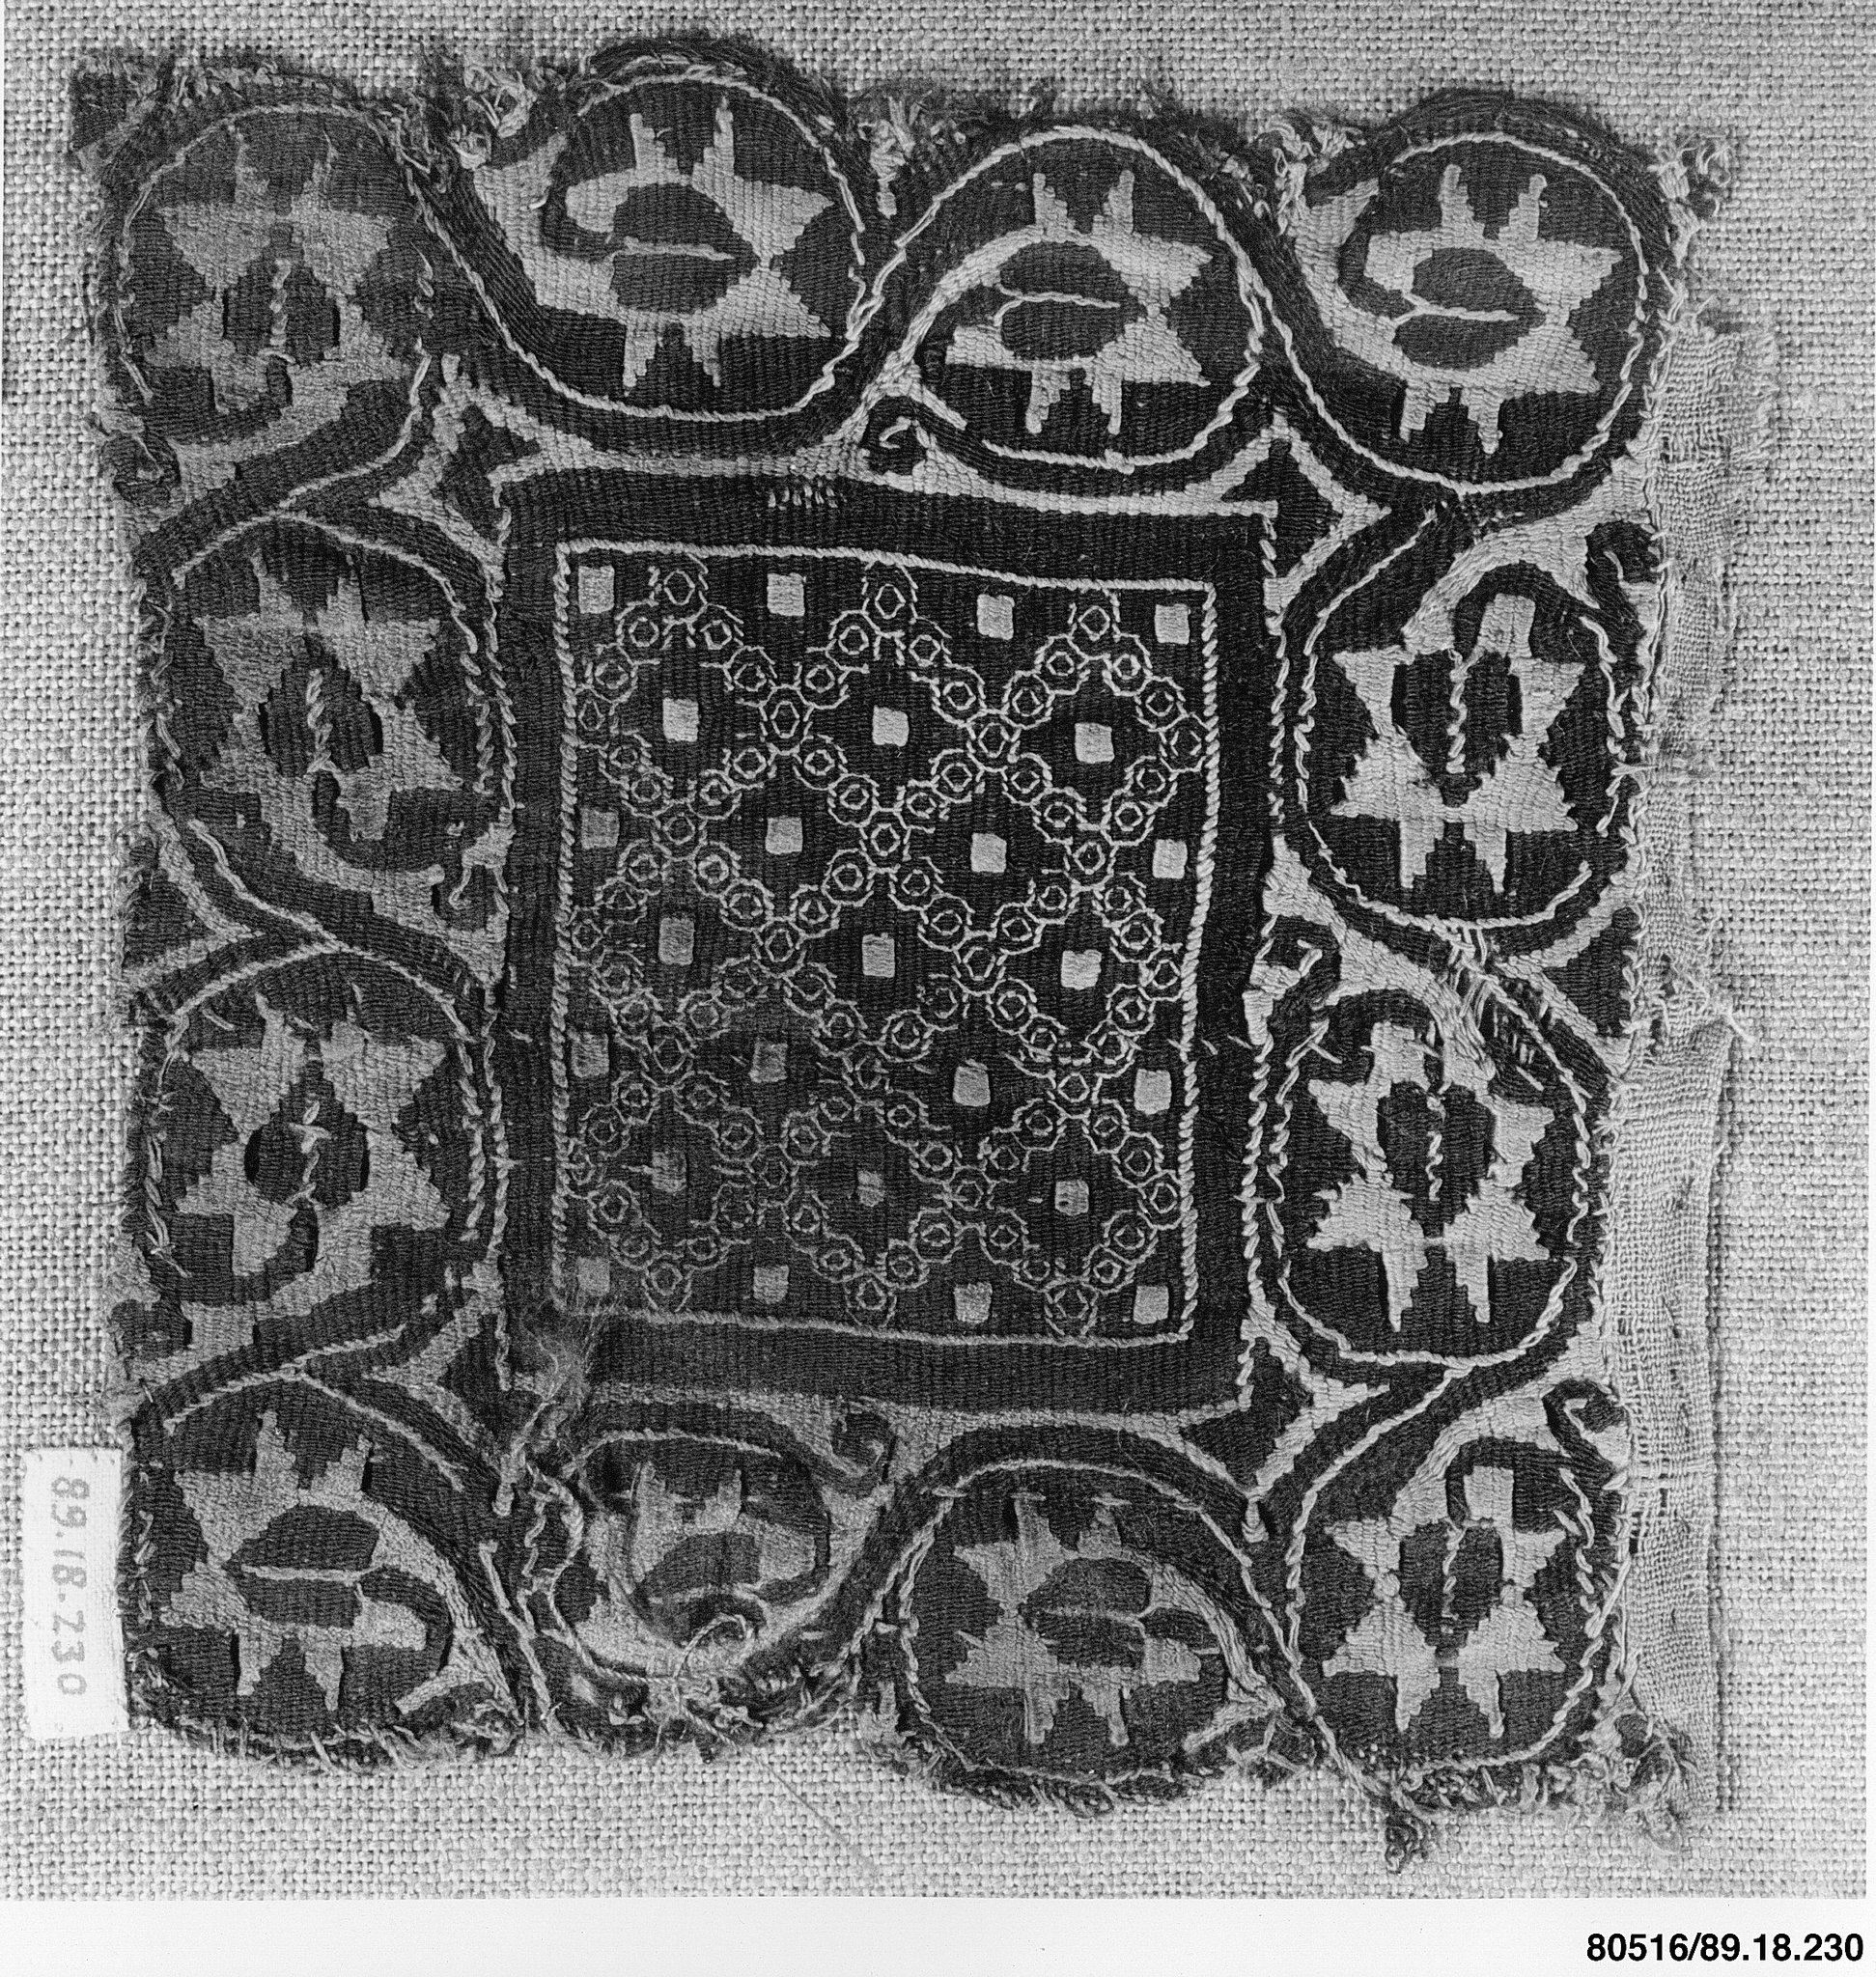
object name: textile fragment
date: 301-400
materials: linen, wool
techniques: weave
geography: egypt